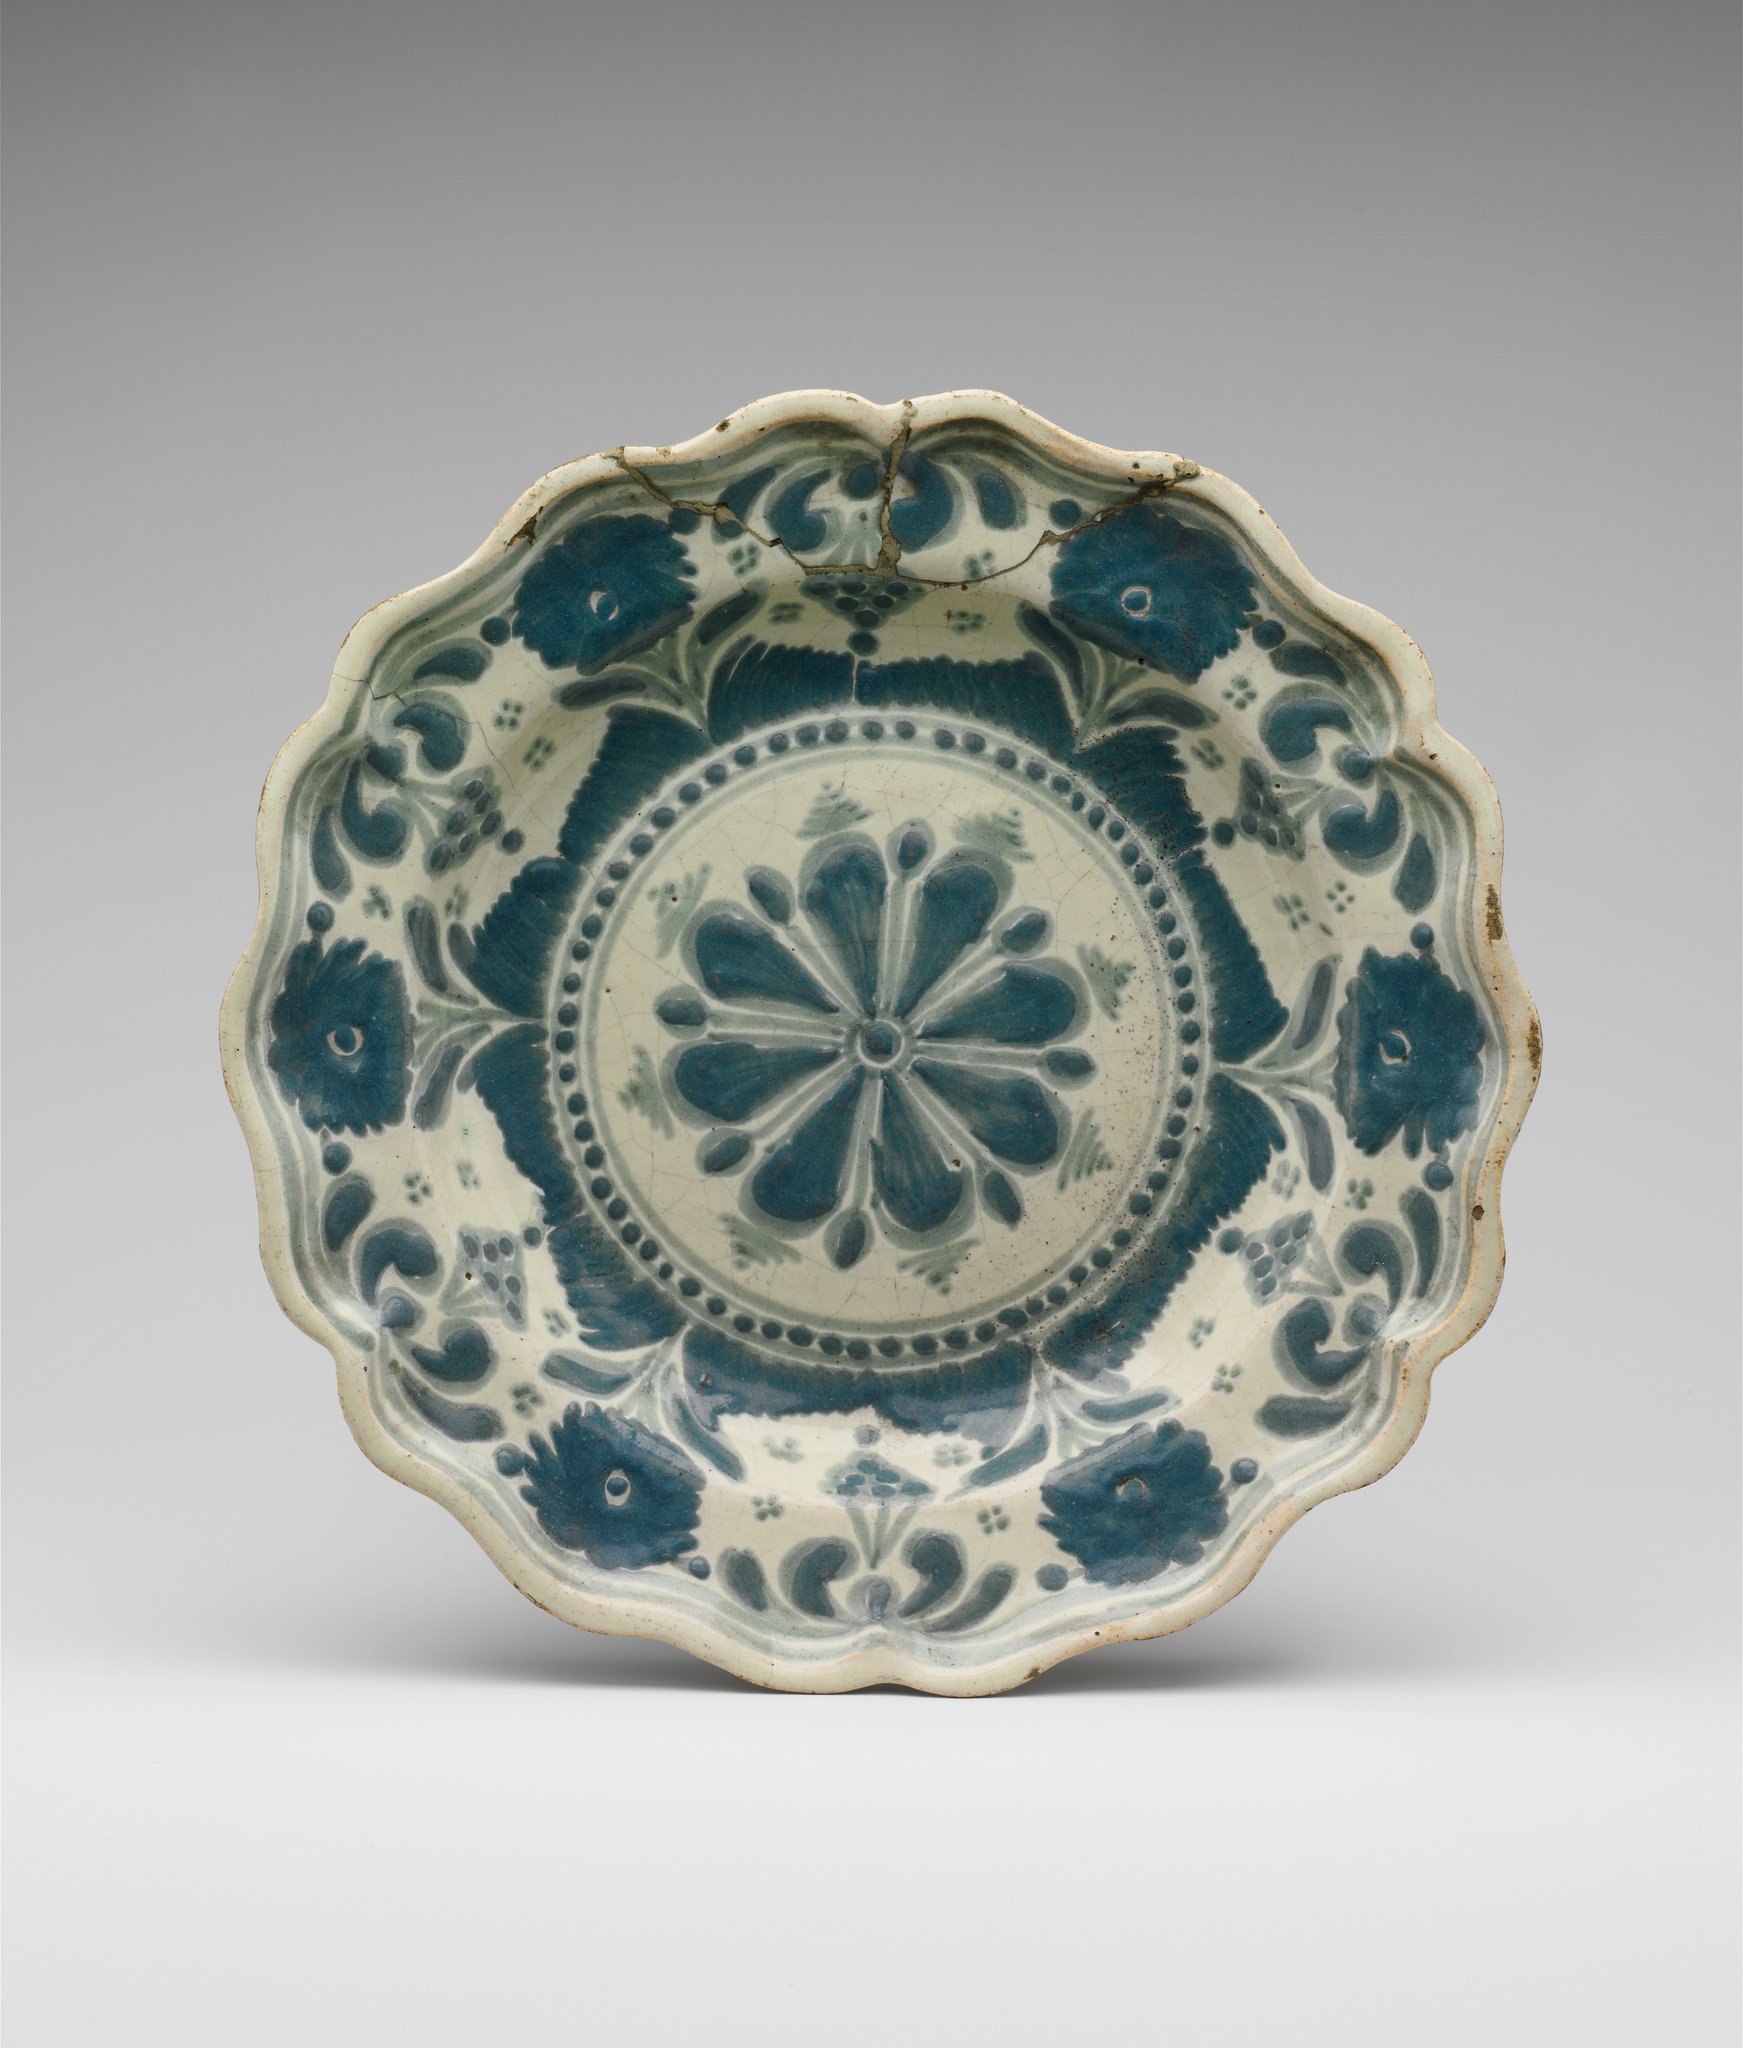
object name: plate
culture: mexican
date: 1825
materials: earthenware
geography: mexico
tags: flowers